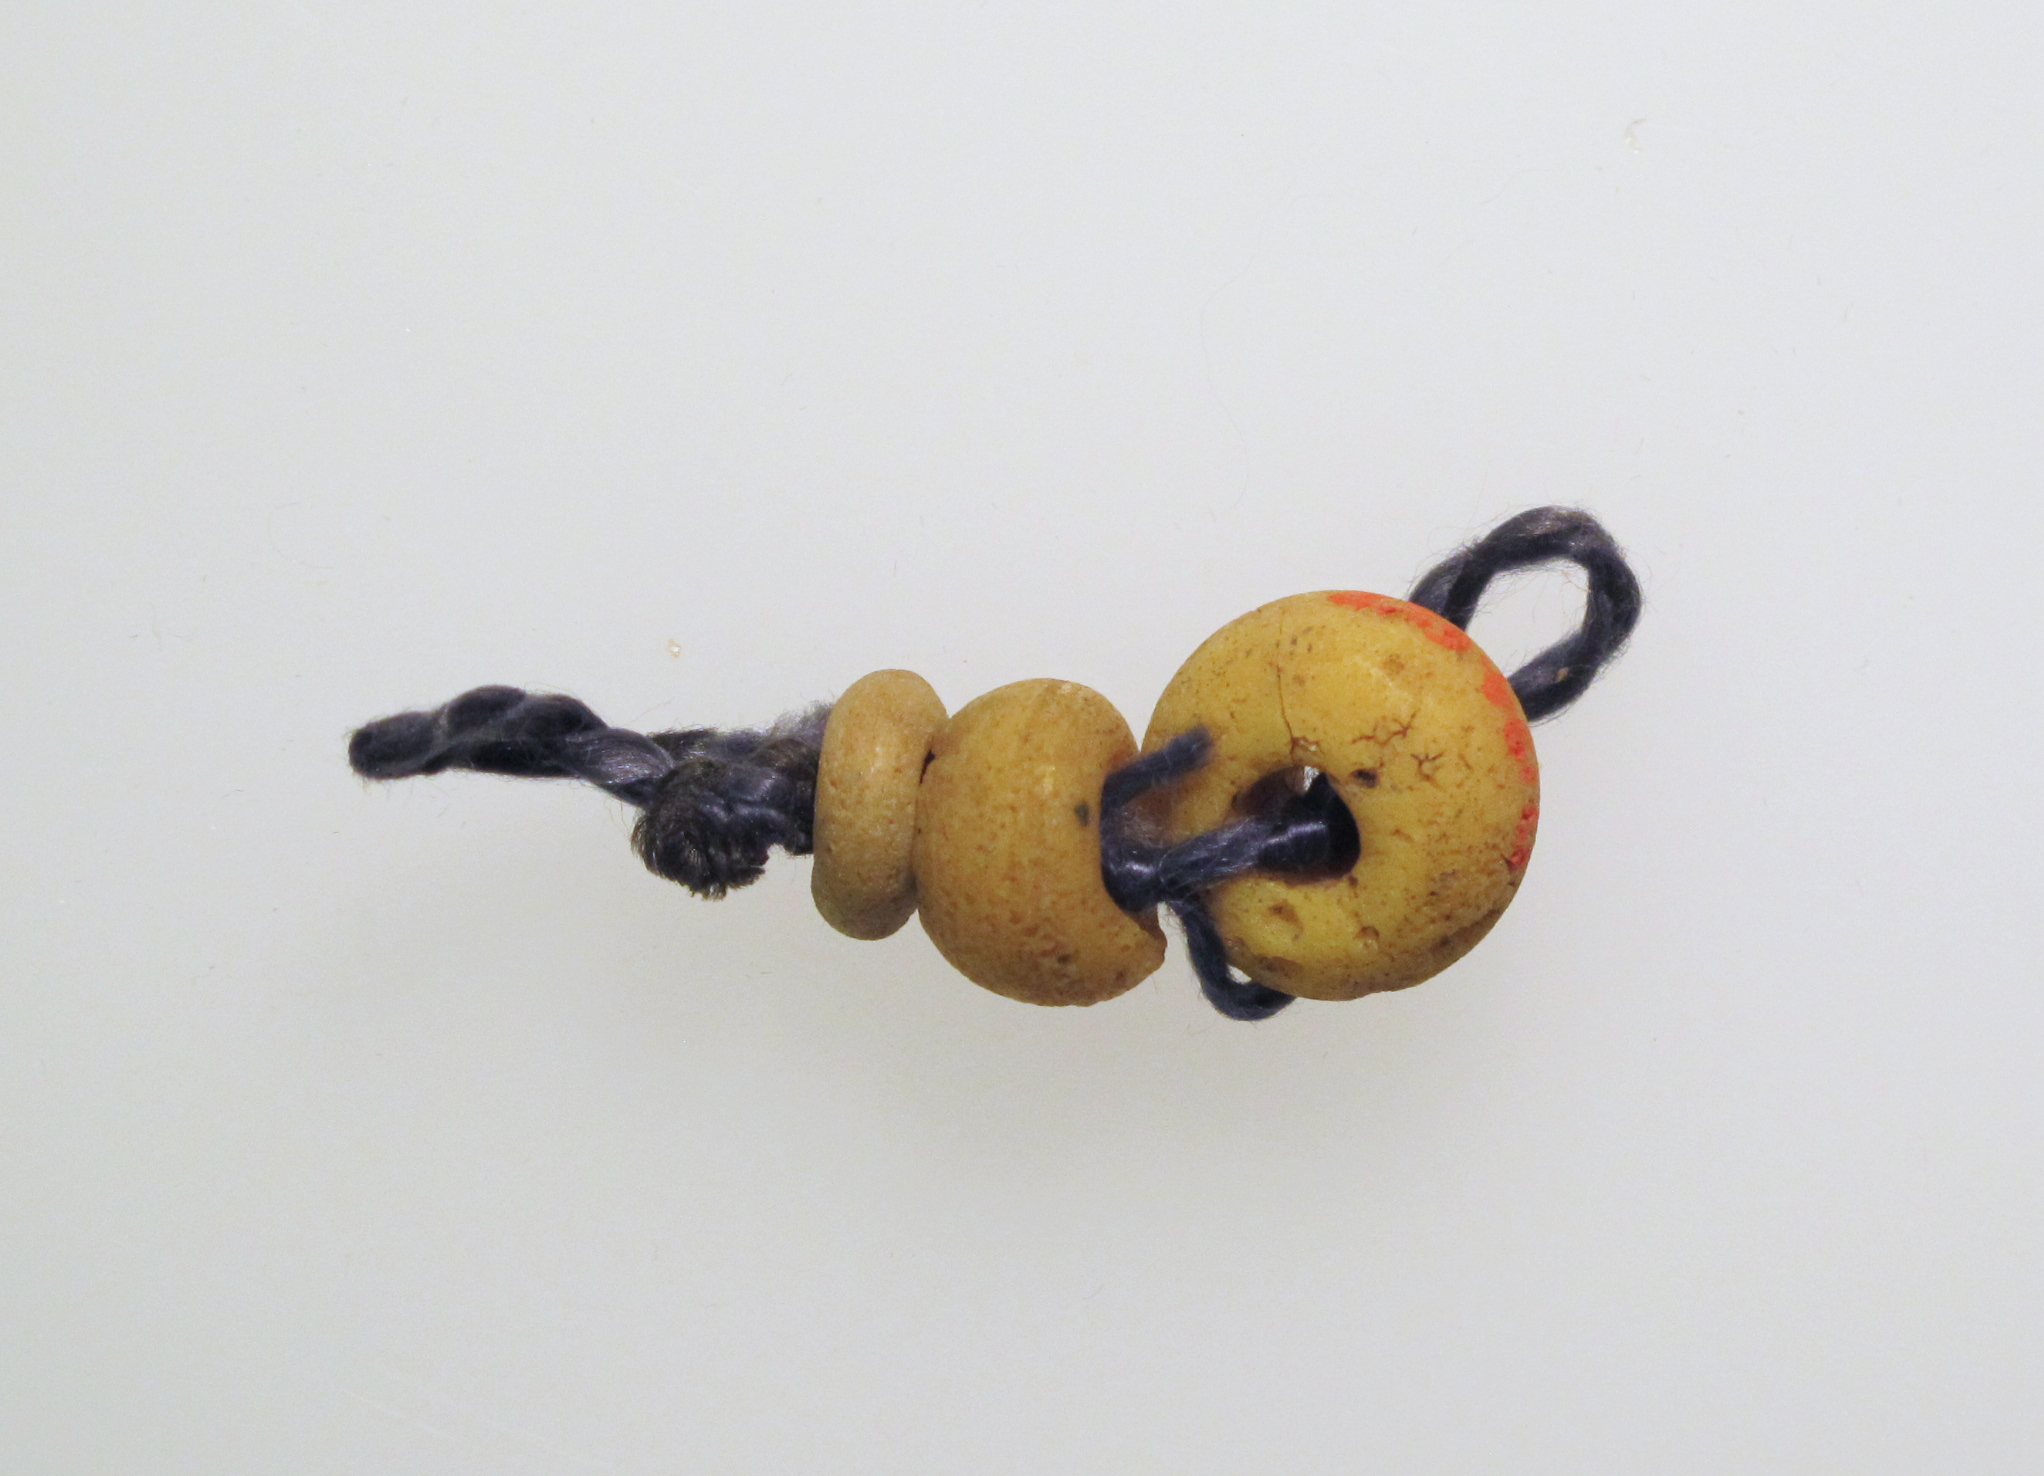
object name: bead, 3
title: Beads, 3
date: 7000 BCE-330 CE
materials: glass